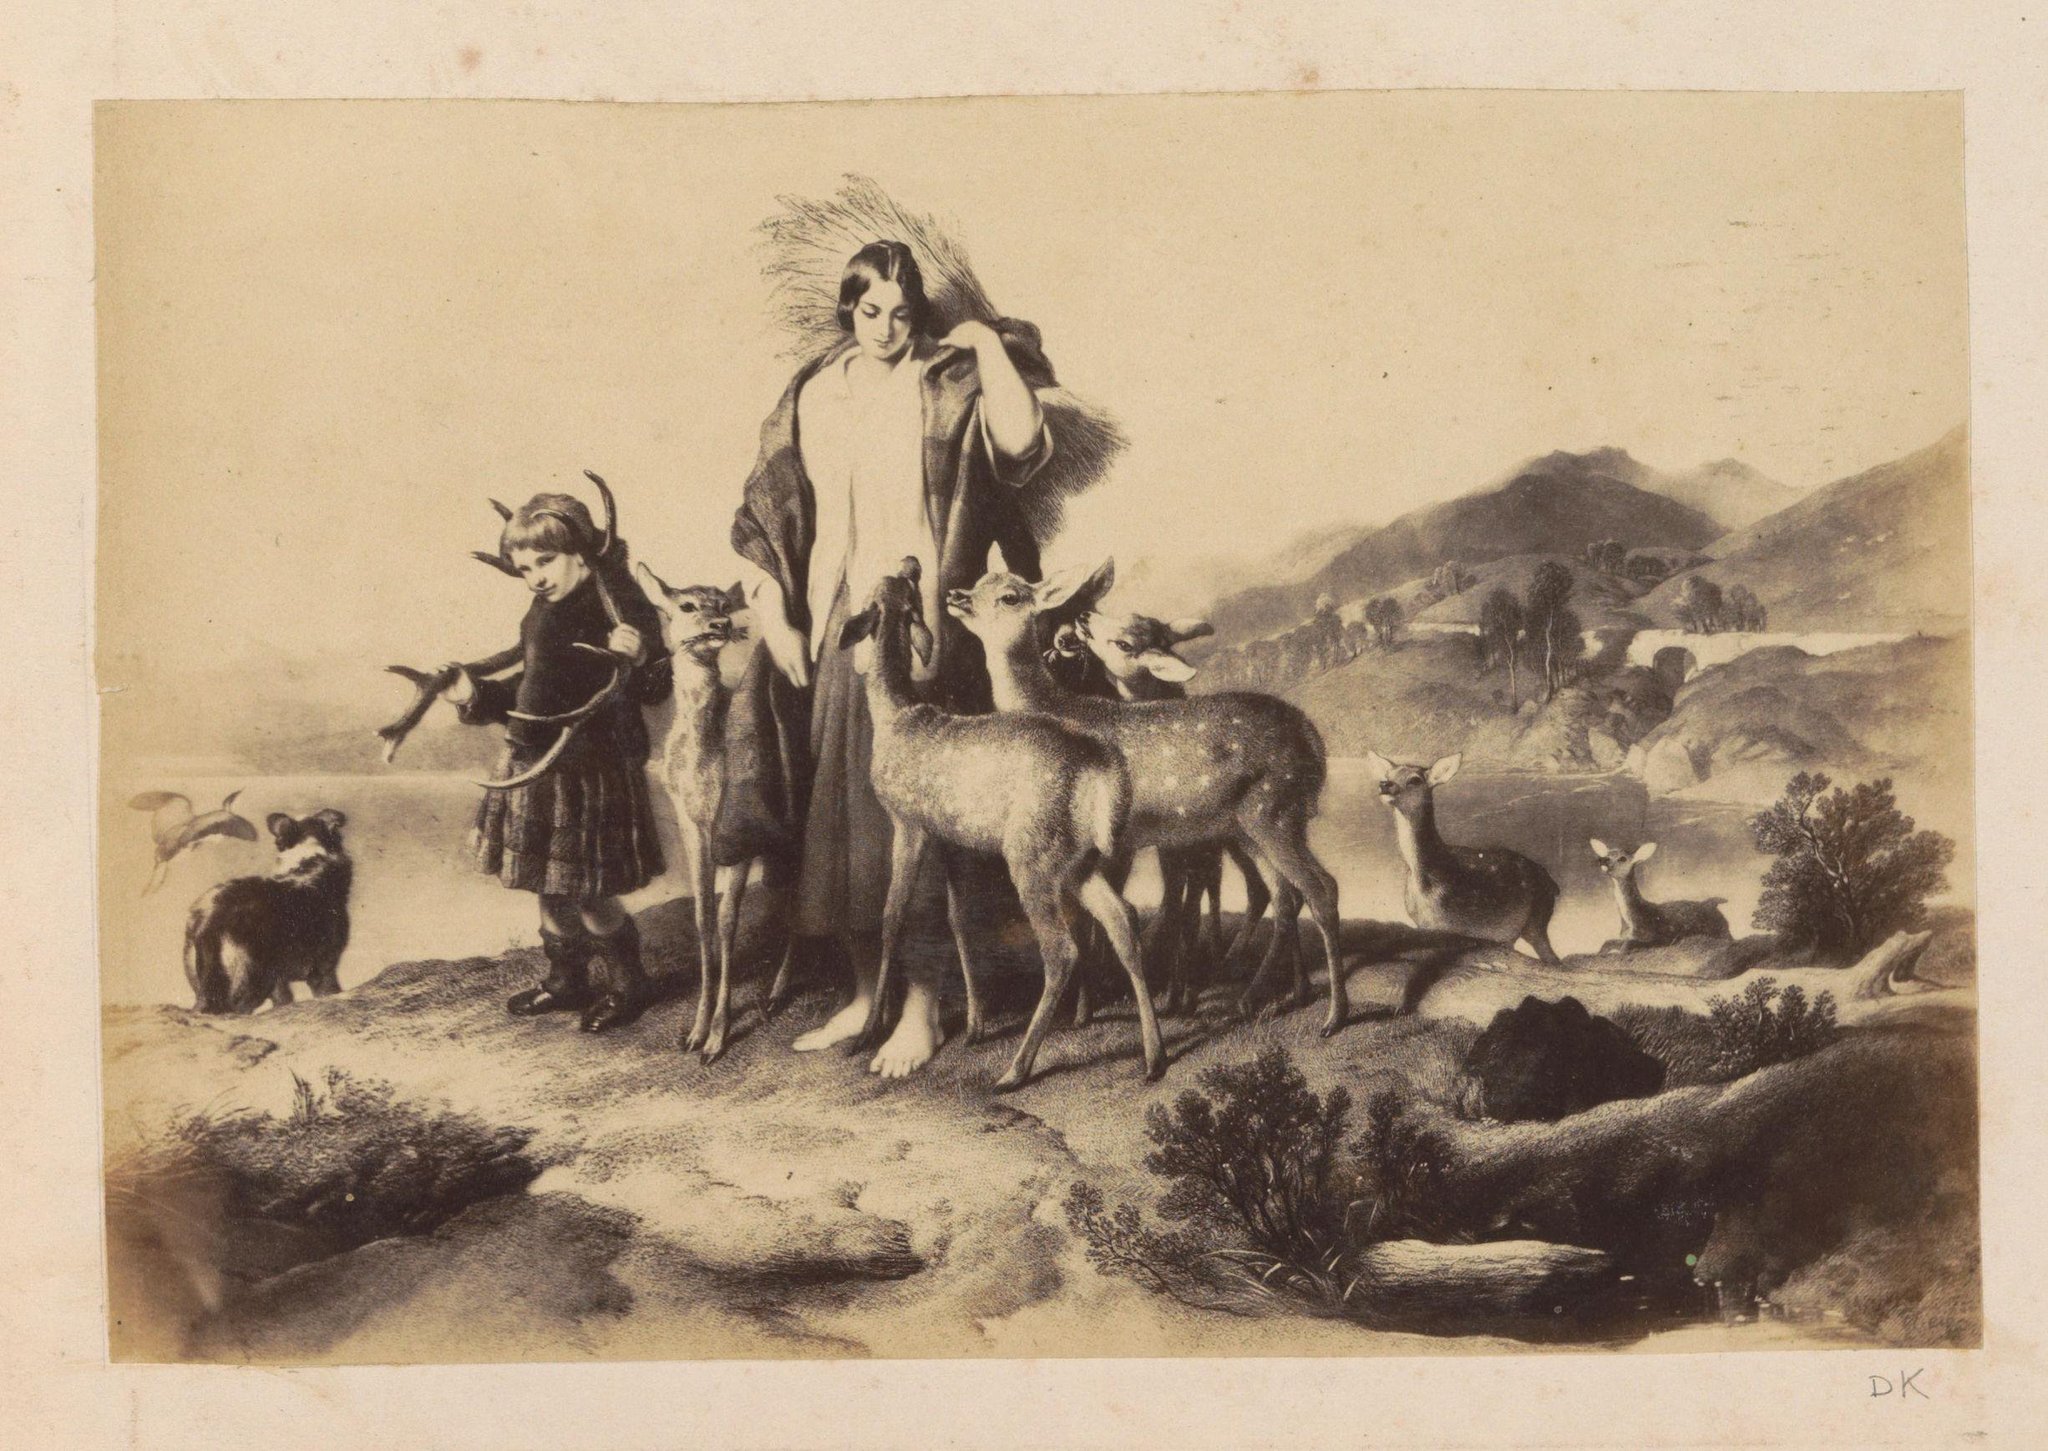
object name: photograph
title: Fotoreproductie van (vermoedelijk) een prent van een vrouw en een kind temidden van reeën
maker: Anonymous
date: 1850-1870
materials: paper, photographic support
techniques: albumen print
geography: england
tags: hoofed animals: deer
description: Onderdeel van Album met foto's van bezienswaardigheden en landschappen in Engeland en van kunst.